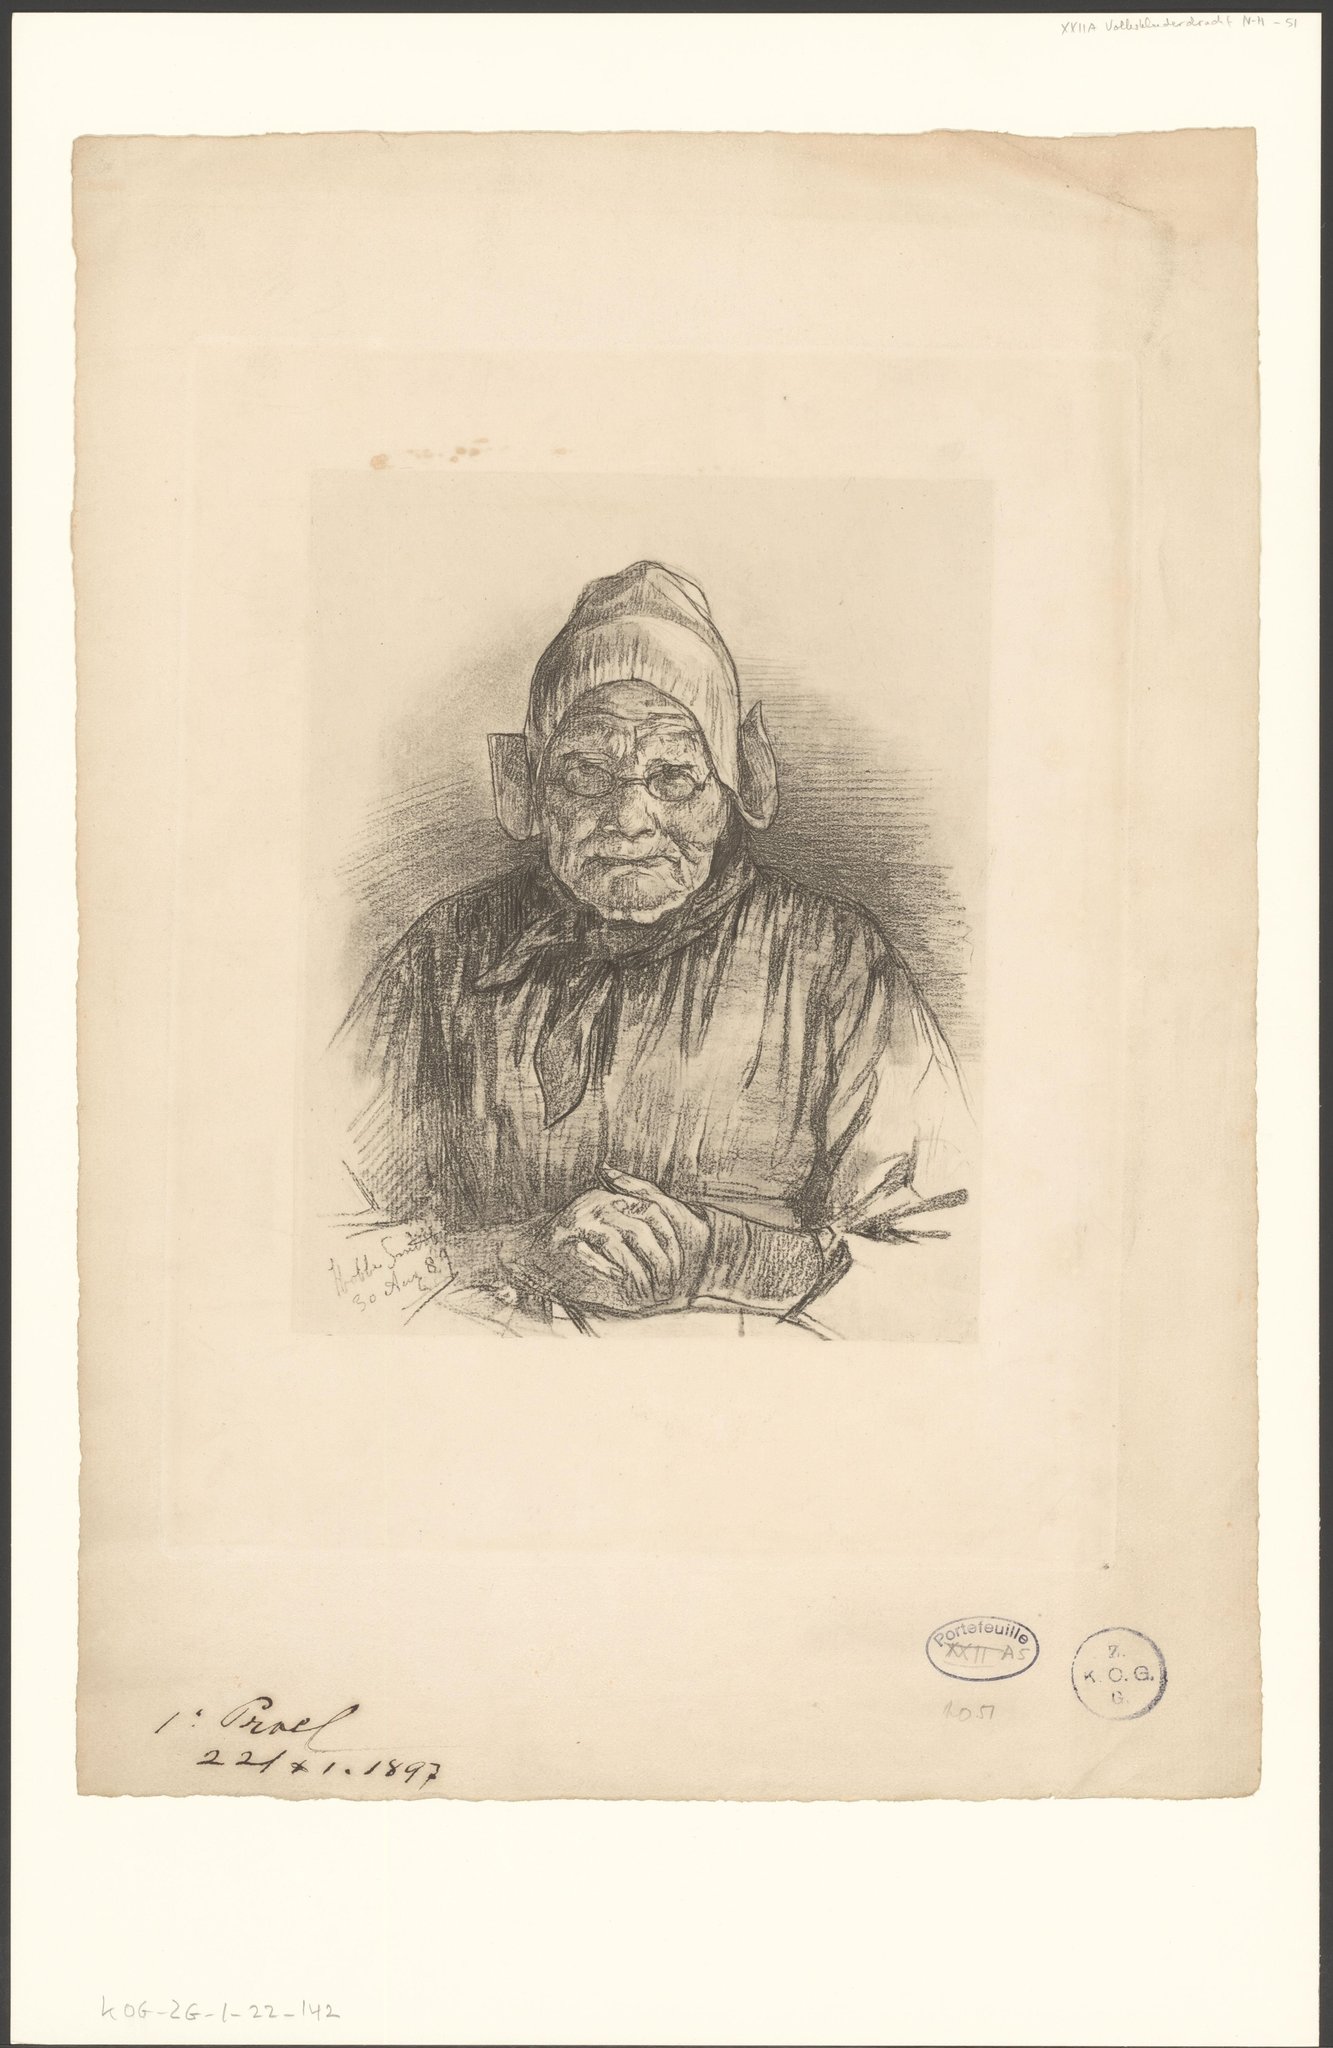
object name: print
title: Vrouwenportret met kap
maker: hobbe smith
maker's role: painter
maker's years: 1862-1942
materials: paper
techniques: lithograph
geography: netherlands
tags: clothes, costume (+ women's clothes), old woman, folk costume, regional costume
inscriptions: date: ‘1e Proef 22 / x 1. 1897’, collector's mark: Lugt 1641, collector's mark, date:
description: Portret van een oude vrouw met een kapje op het hoofd. Mogelijk Volendam. Onderwerpsrubrieken binnen de Atlas Zeden en Gewoonten: De Kleeding, Volkskleederdracht, Noord-Holland.